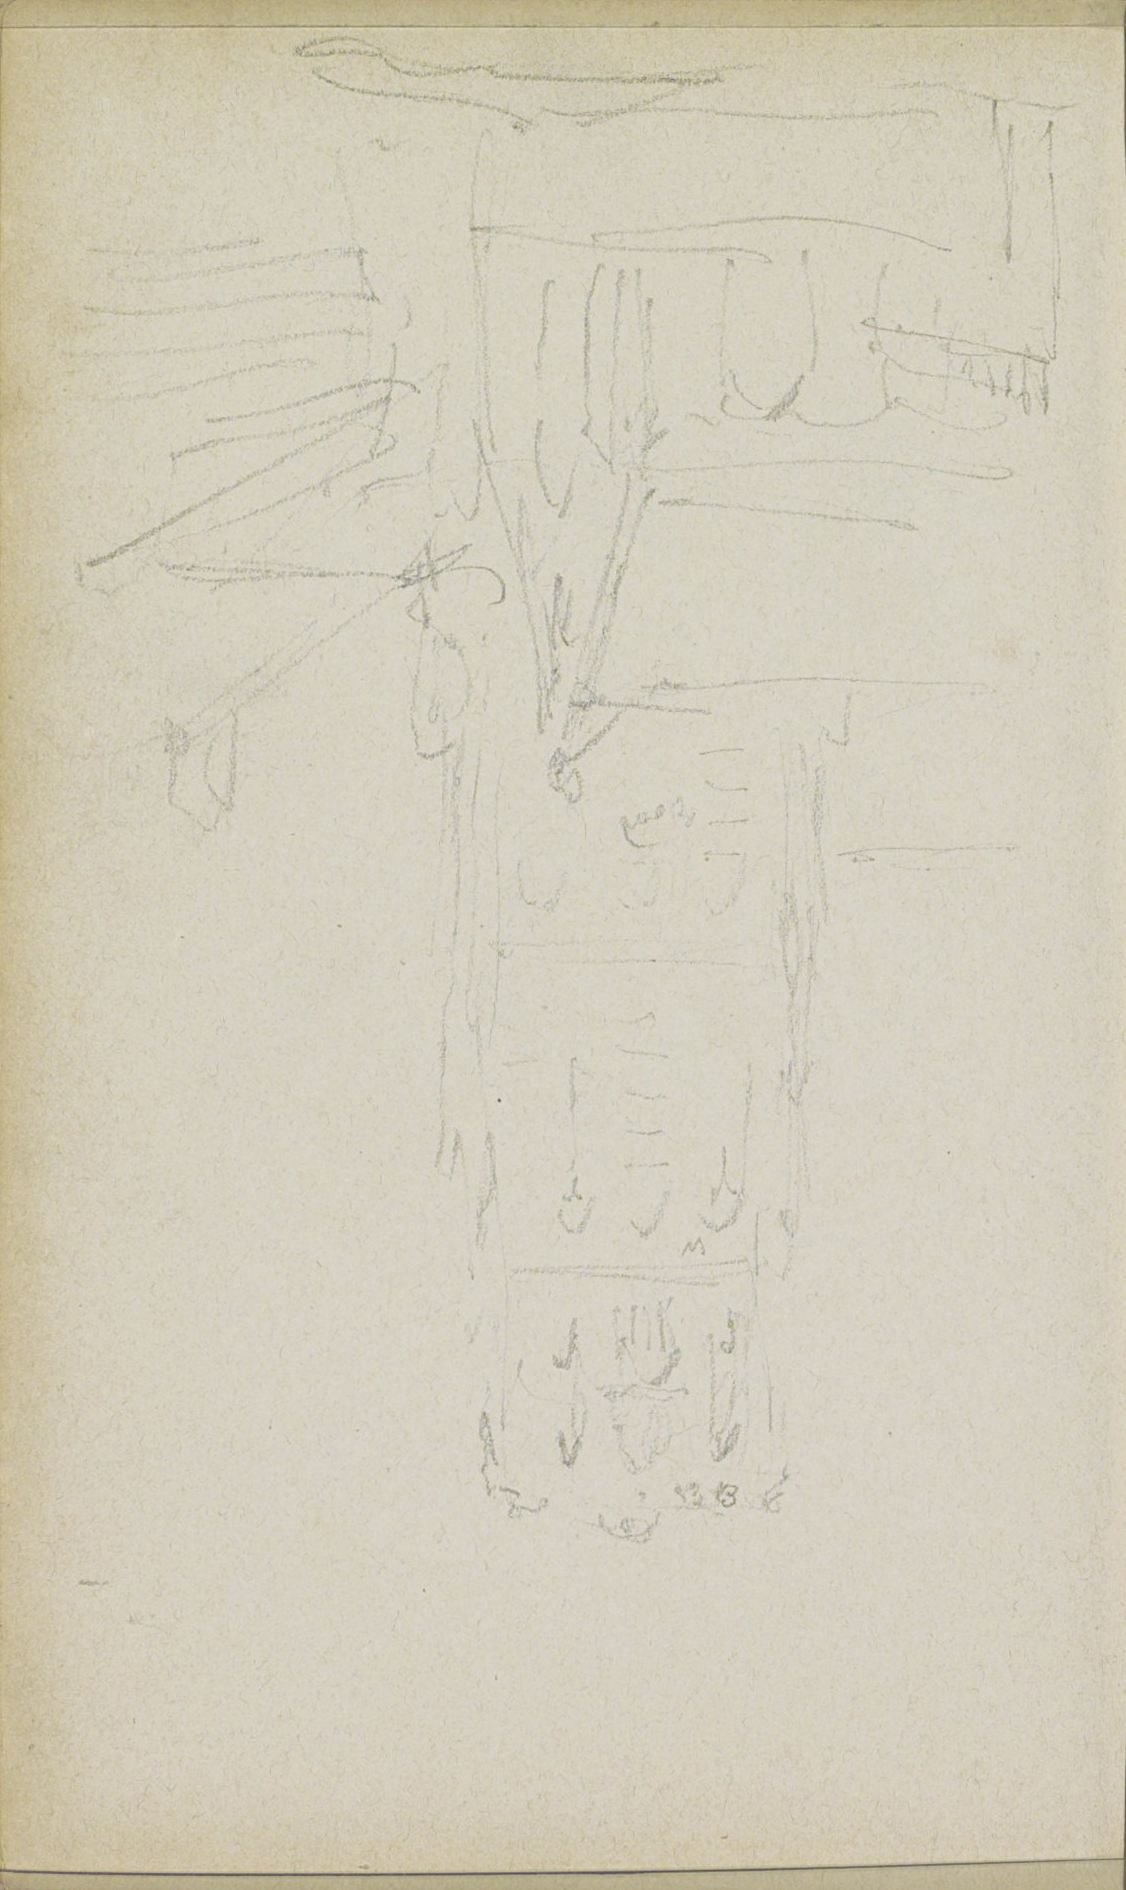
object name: sketchbook leaf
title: Gezicht op een kerk, mogelijk de Sint-Catharijnekerk te Brielle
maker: adrianus eversen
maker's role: draughtsman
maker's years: 1818-1897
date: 1828-1897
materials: paper, pencil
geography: netherlands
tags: church (exterior), street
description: Gezicht op een straat met een kerk, mogelijk de Sint-Catharijnekerk te Brielle. Blad 44 verso uit een schetsboek met 69 bladen vervaardigd in de omgeving van Delft, Rotterdam, Oudewater en Harlingen.